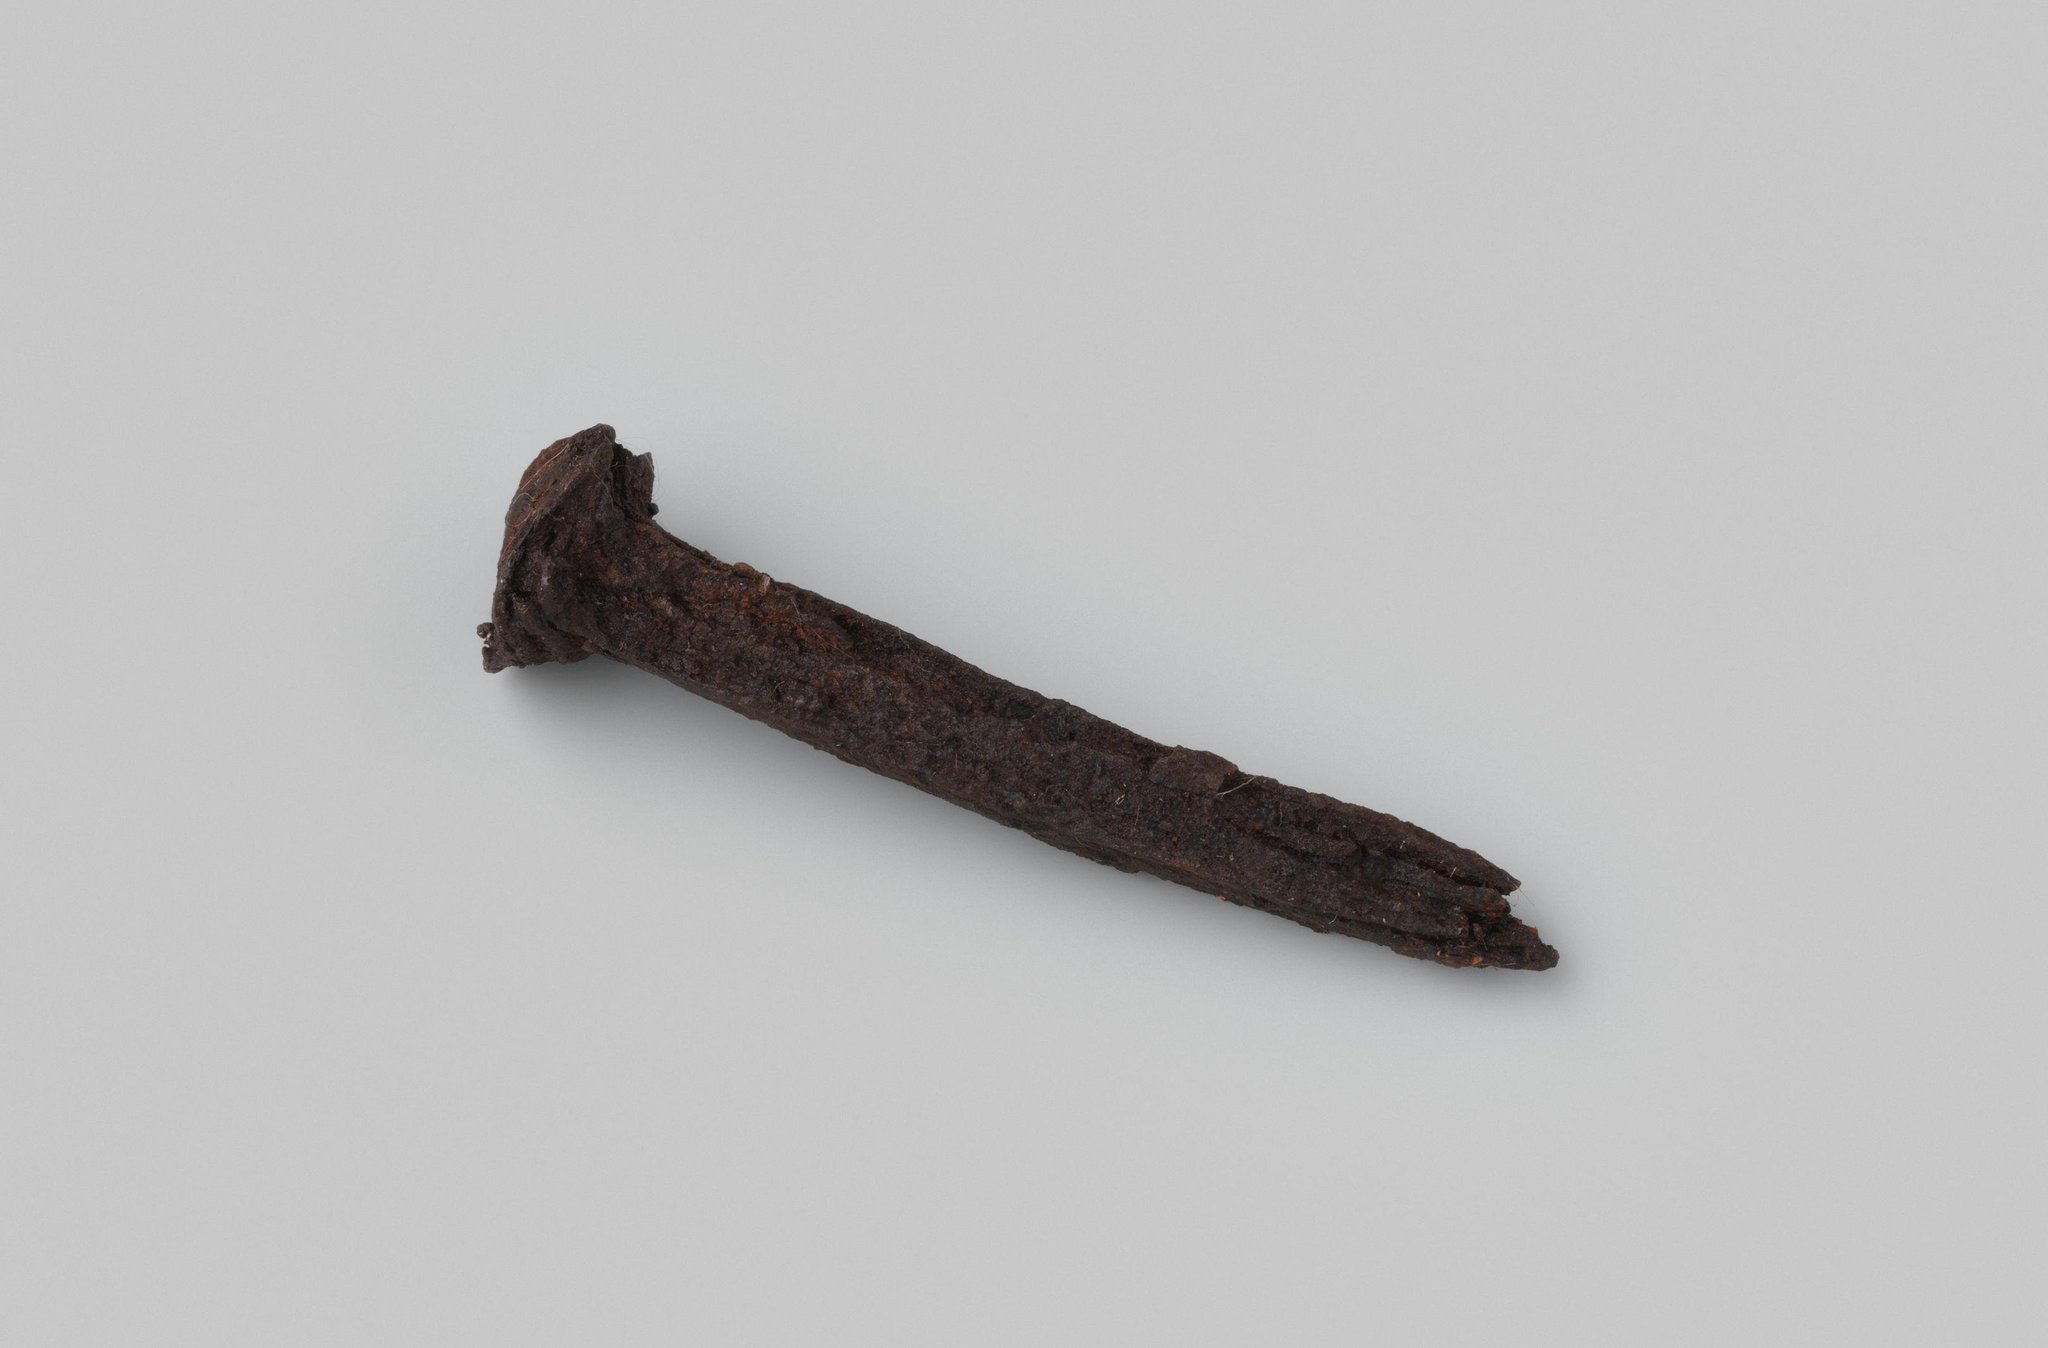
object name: nagel, spijker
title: Spijker afkomstig uit het wrak van de Oost-Indiëvaarder Hollandia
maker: Anonymous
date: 1700-1743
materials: iron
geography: netherlands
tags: verenigde oostindische compagnie, hollandia (schip)